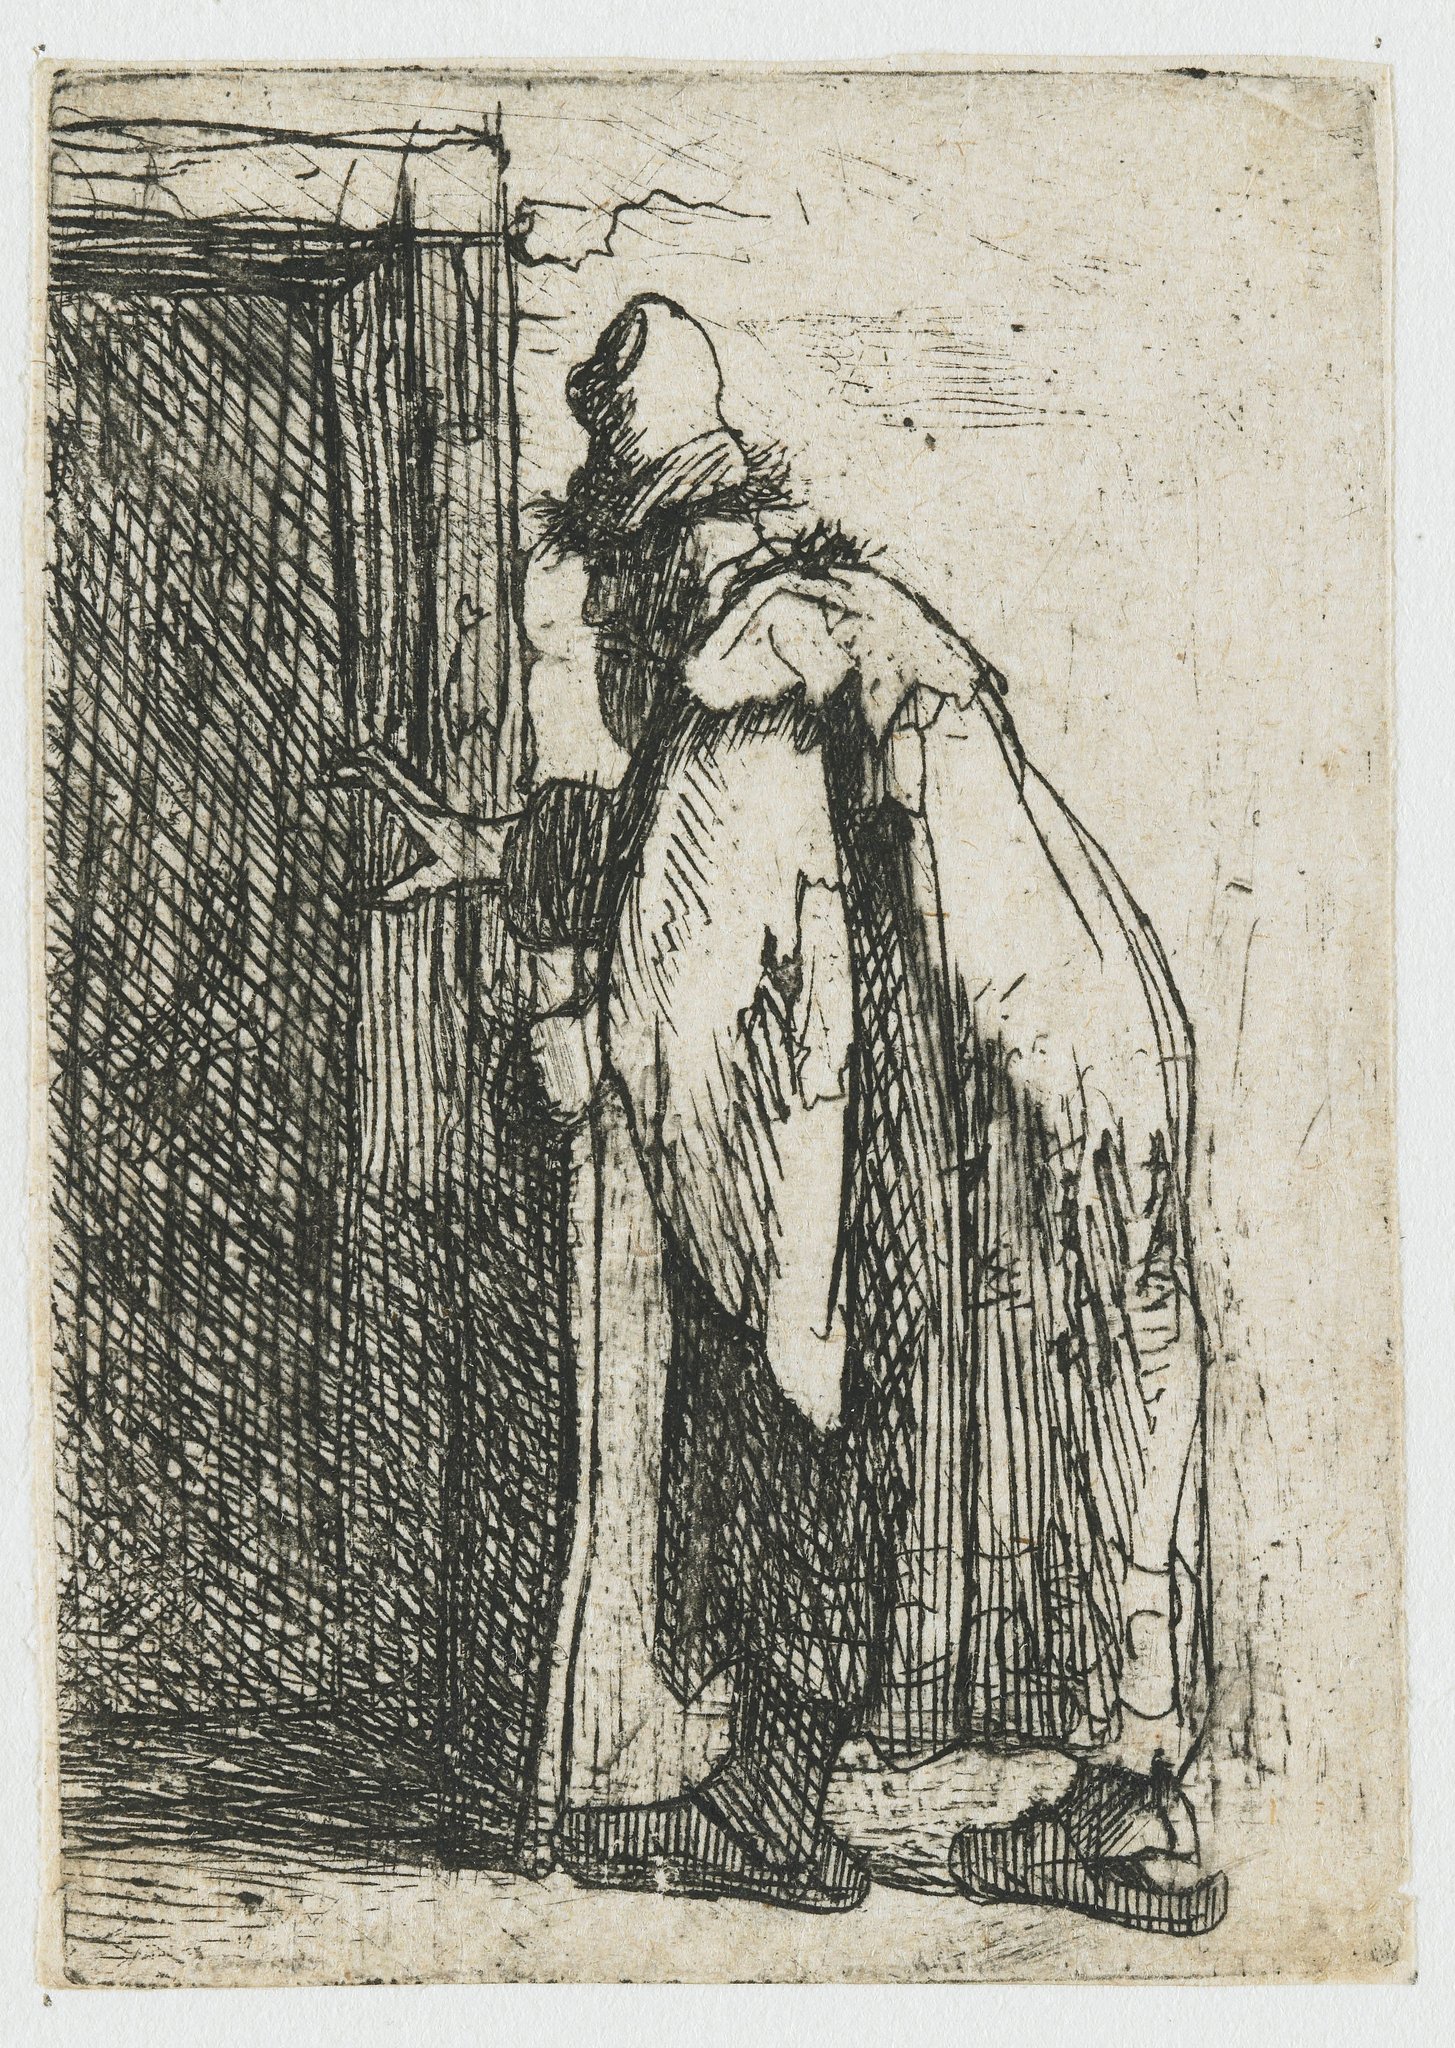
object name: print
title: The blindness of Tobit: a sketch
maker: rembrandt van rijn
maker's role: draughtsman, painter, print maker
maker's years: 1606-1669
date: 1629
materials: paper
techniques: etching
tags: tobit's blindness (tobit 2 - 3:6)